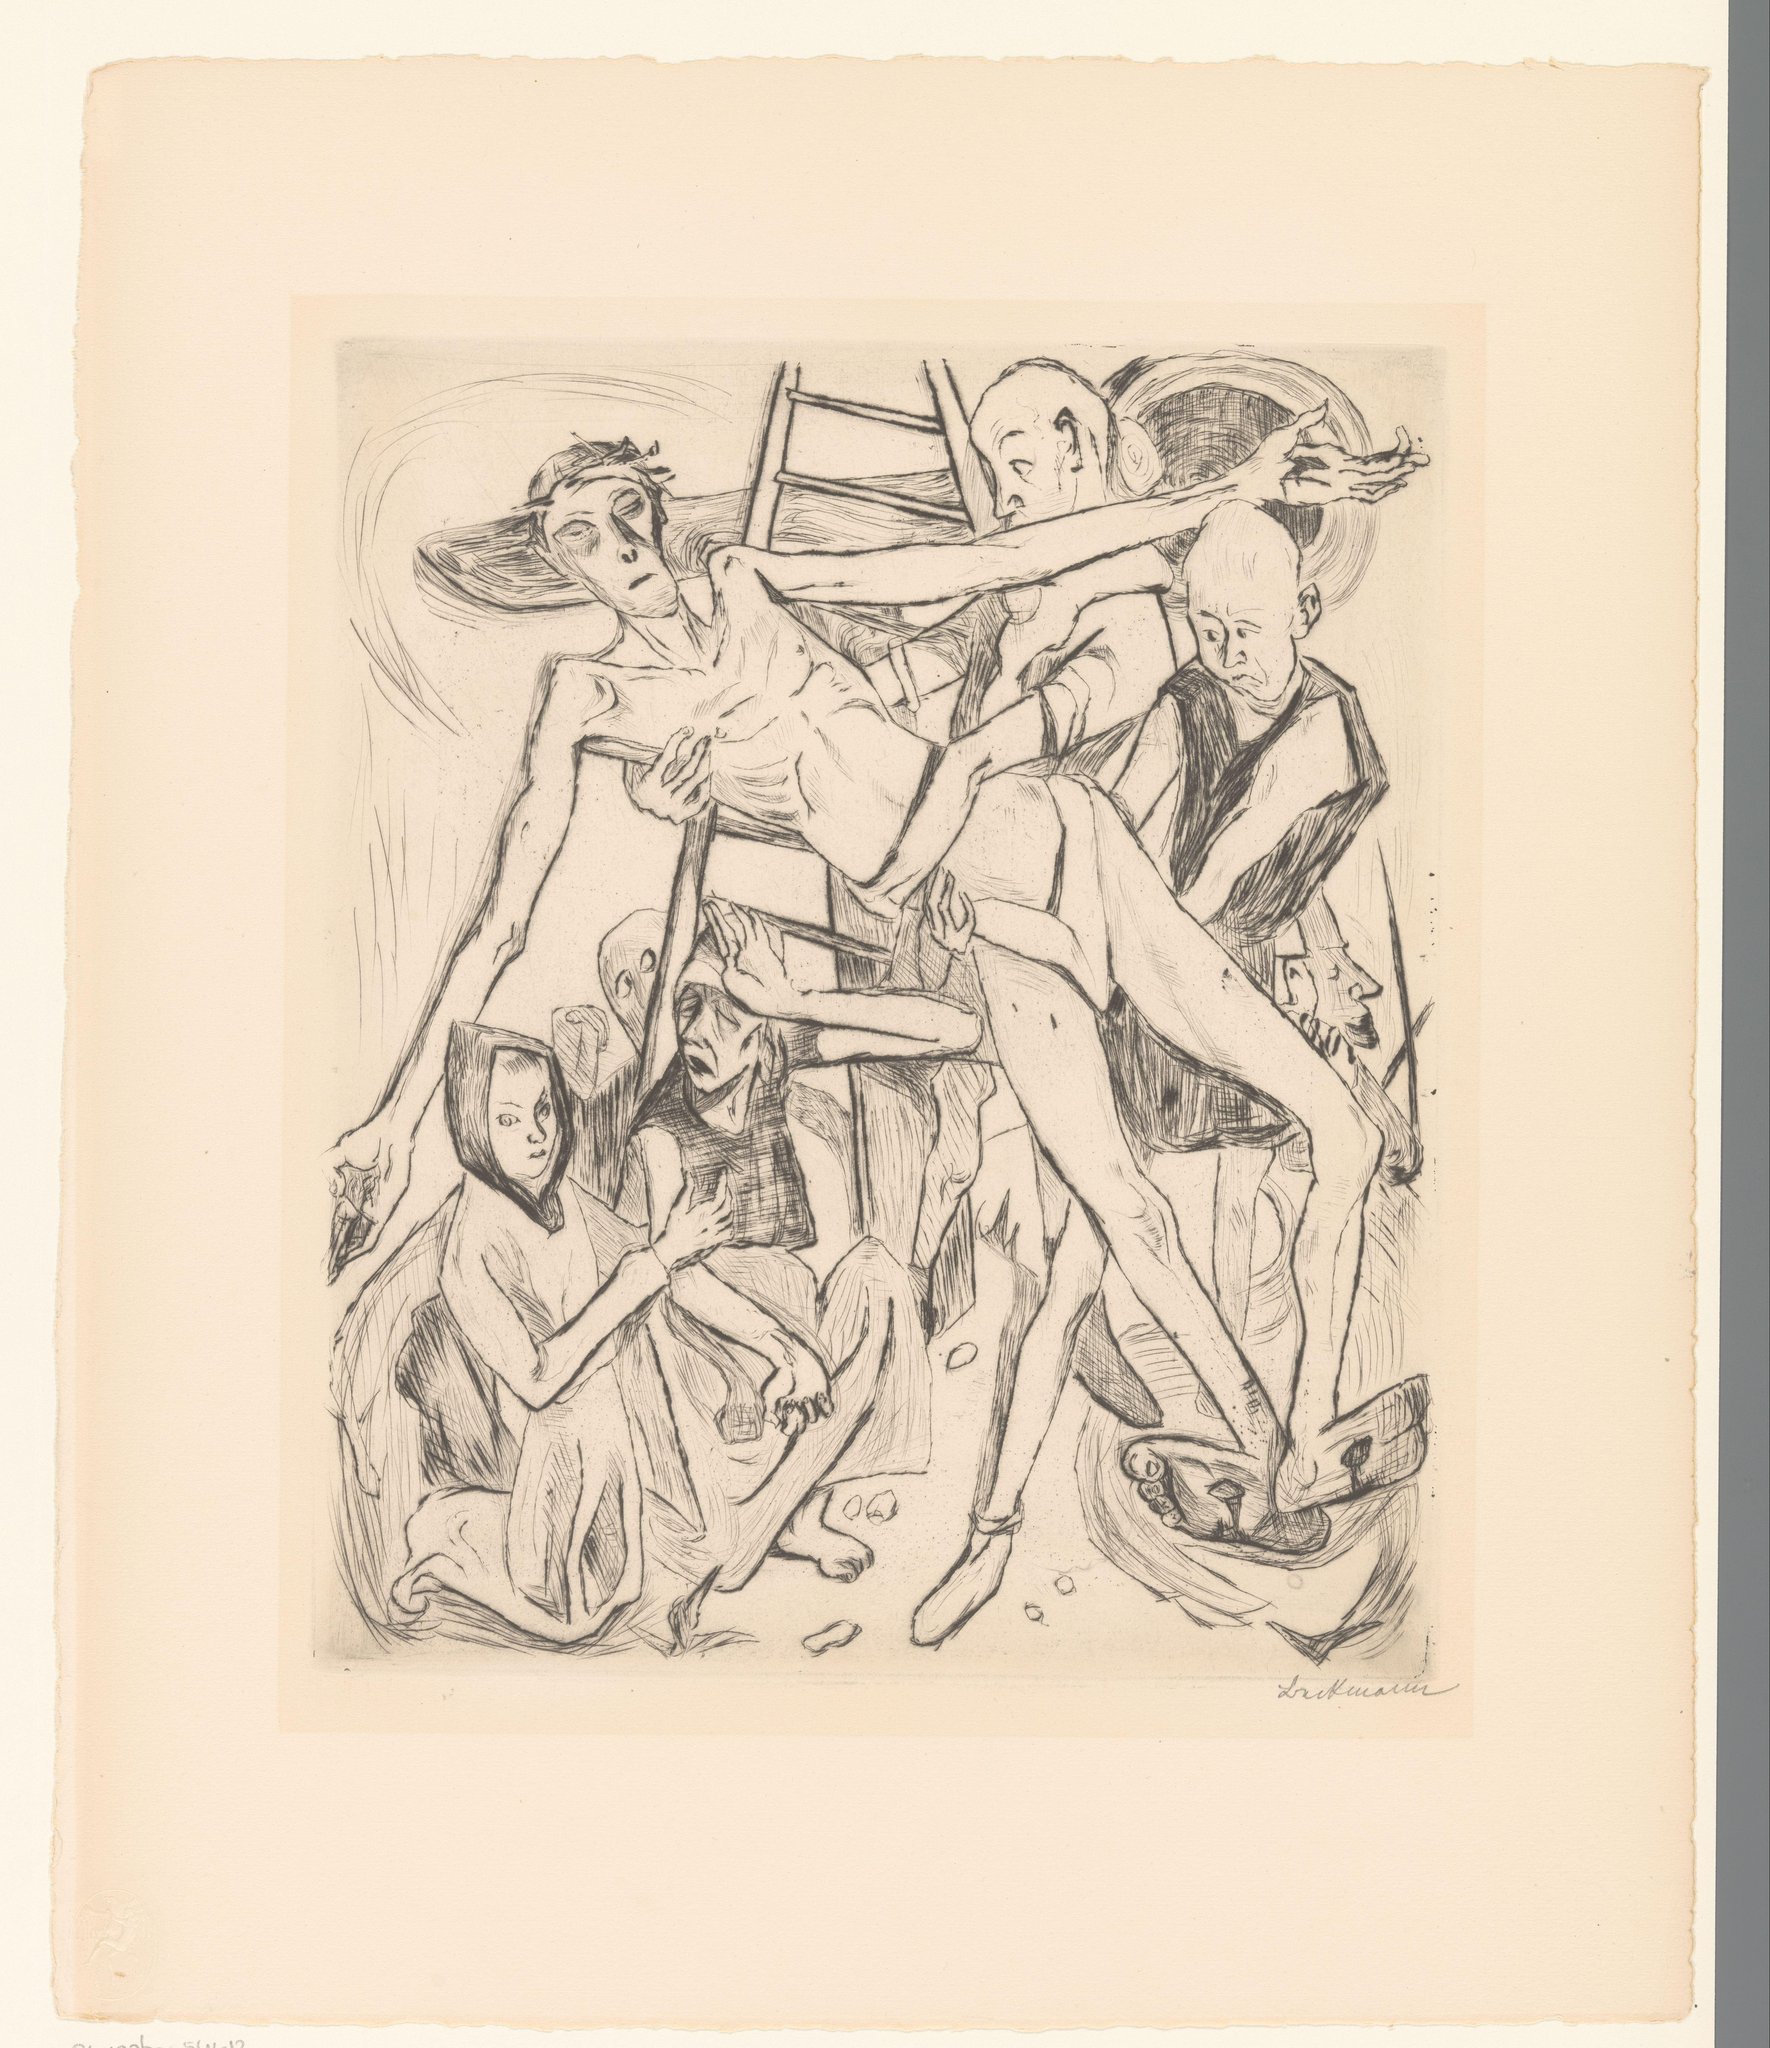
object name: print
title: Kreuzafnahme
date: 1918-1919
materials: paper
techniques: drypoint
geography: munich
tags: descent from the cross: christ is taken down from the cross, usually by nicodemus and joseph of arimathaea who are standing on the ladders (both arms of christ detached)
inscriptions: collector's mark: Lugt 2166, collector's mark: Lugt 5629